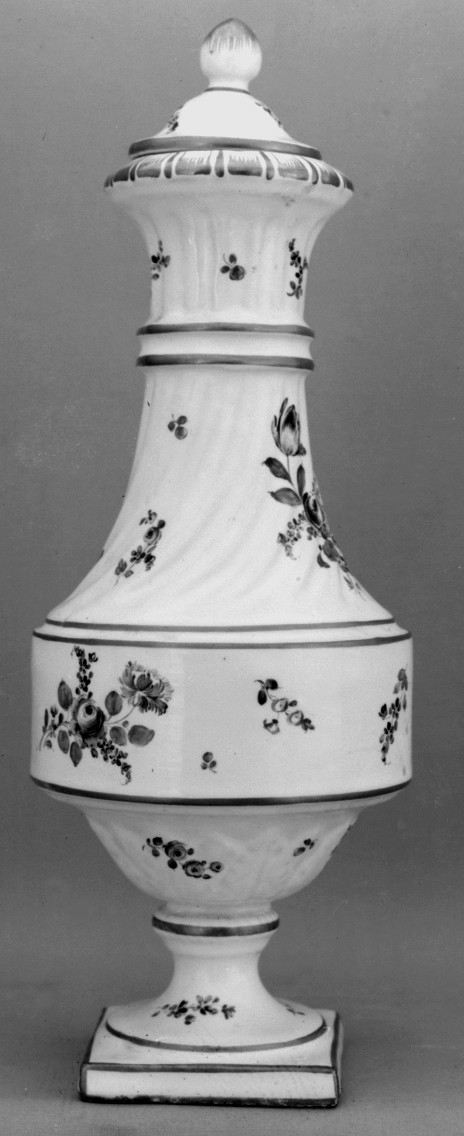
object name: vase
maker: höchst manufactory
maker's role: manufactory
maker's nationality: german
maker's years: 1746-1796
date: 1701-1800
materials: faience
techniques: glazing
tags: flowers